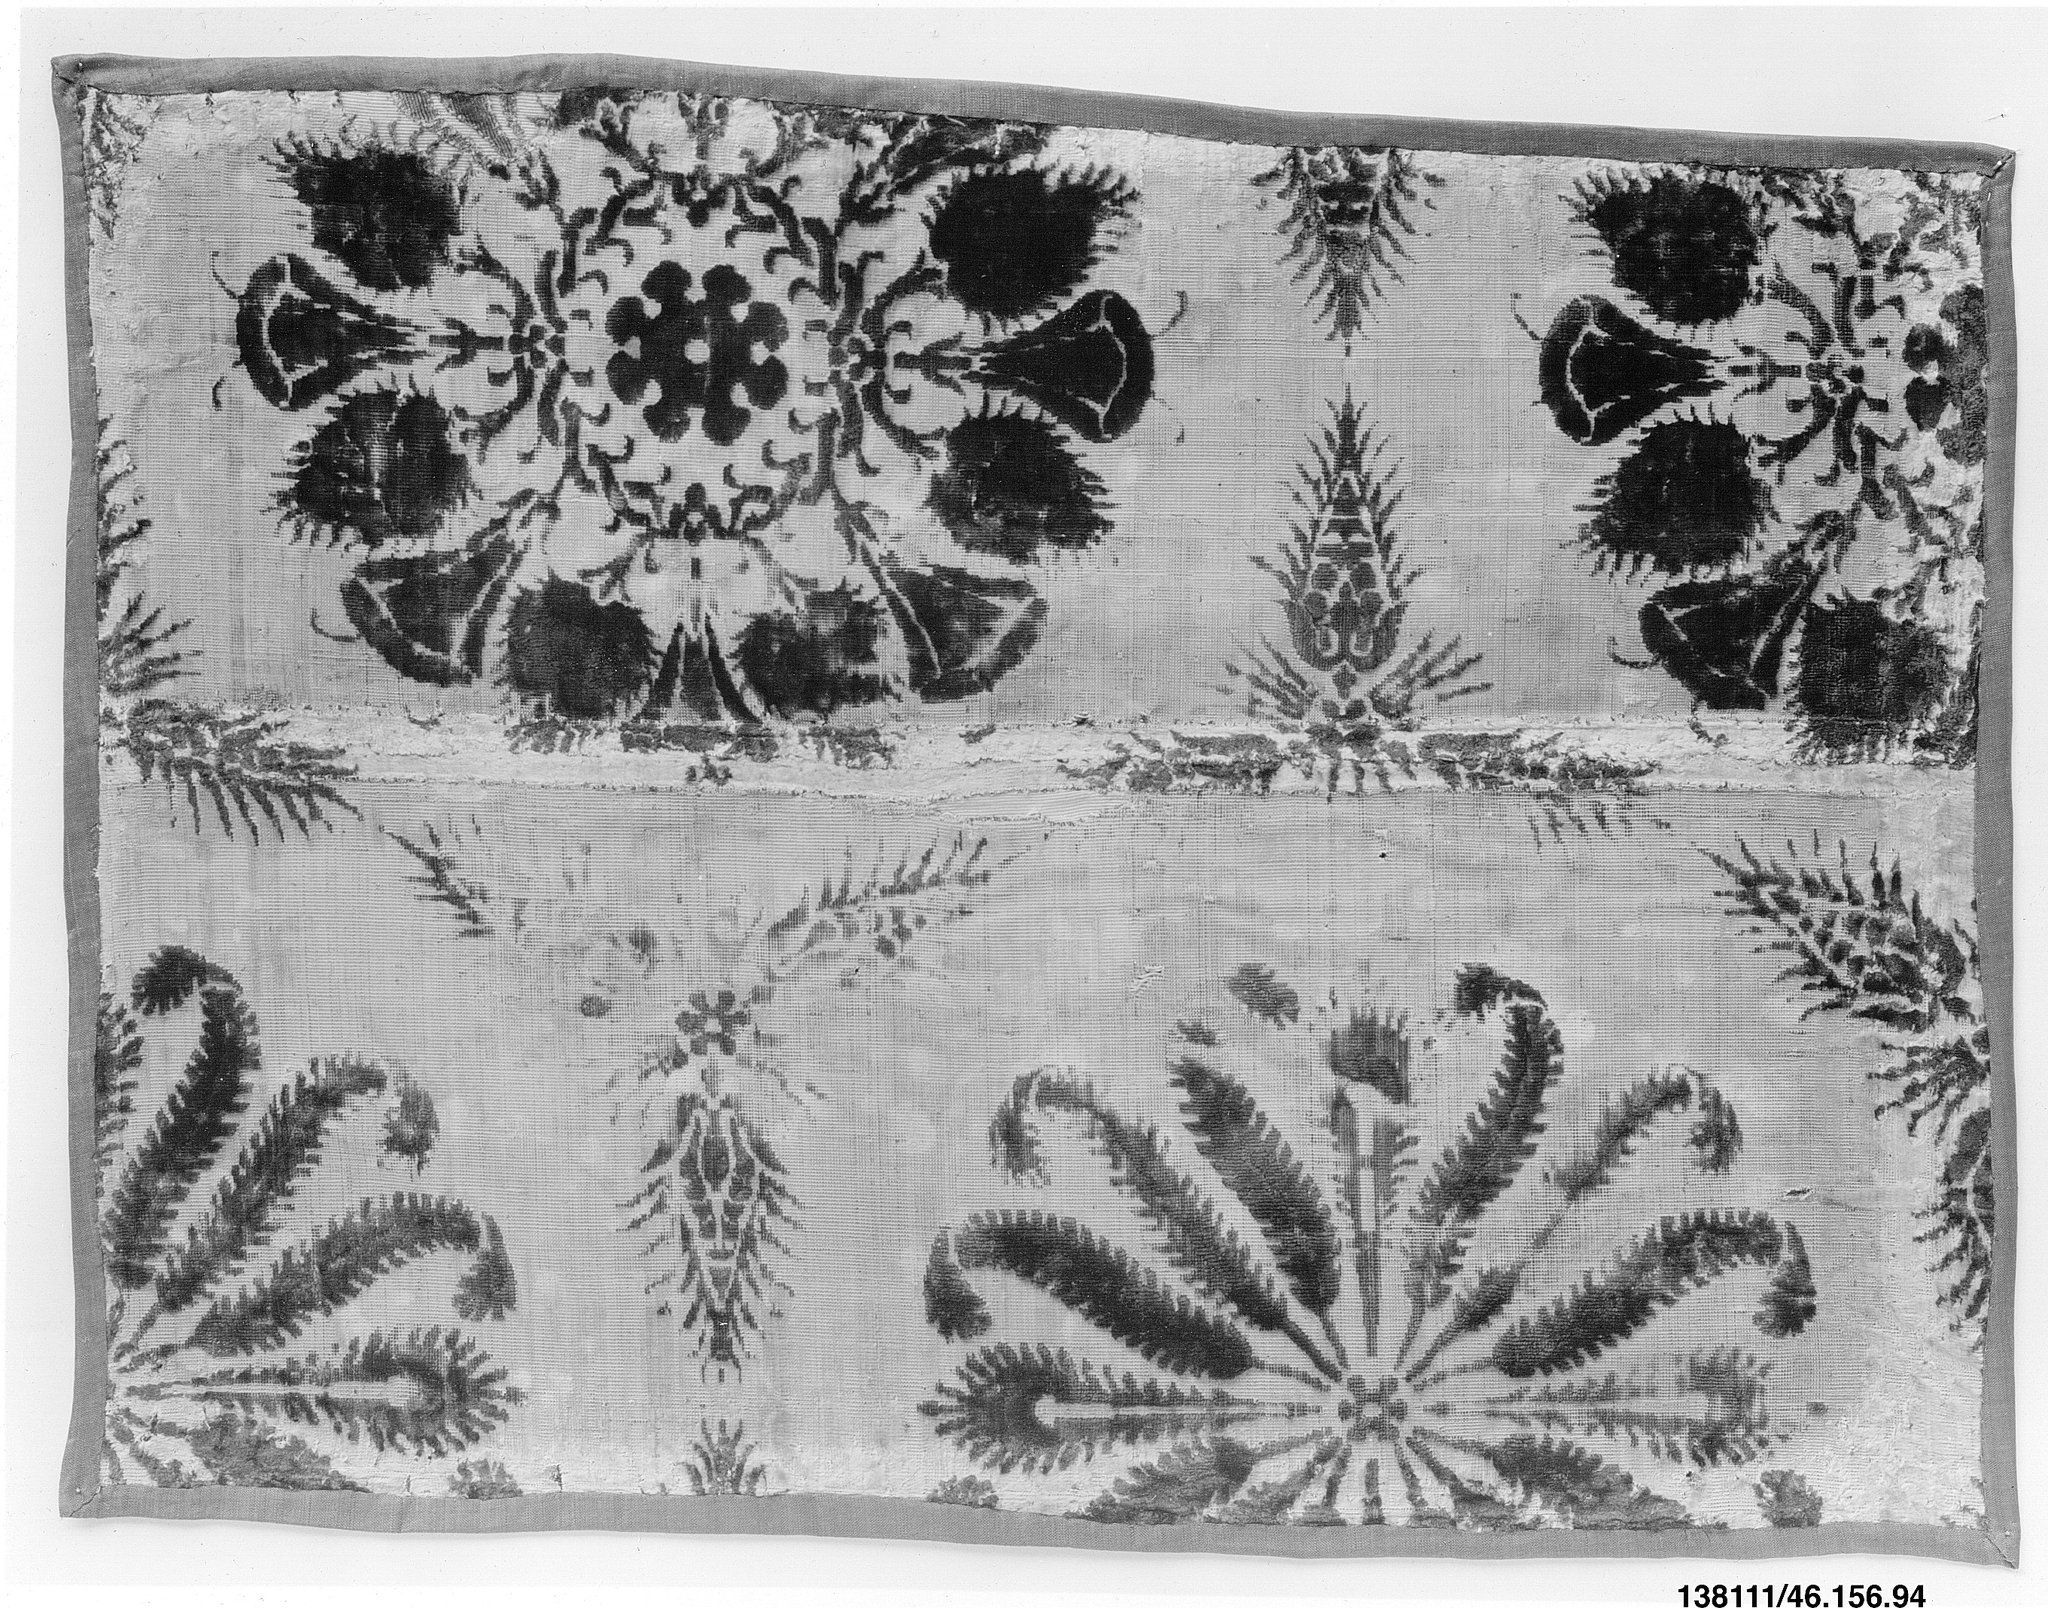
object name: piece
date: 1451-1500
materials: silk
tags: leaves